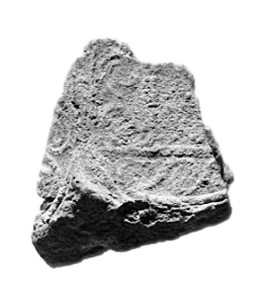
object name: sealing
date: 1981-1640 BCE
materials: mud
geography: egypt